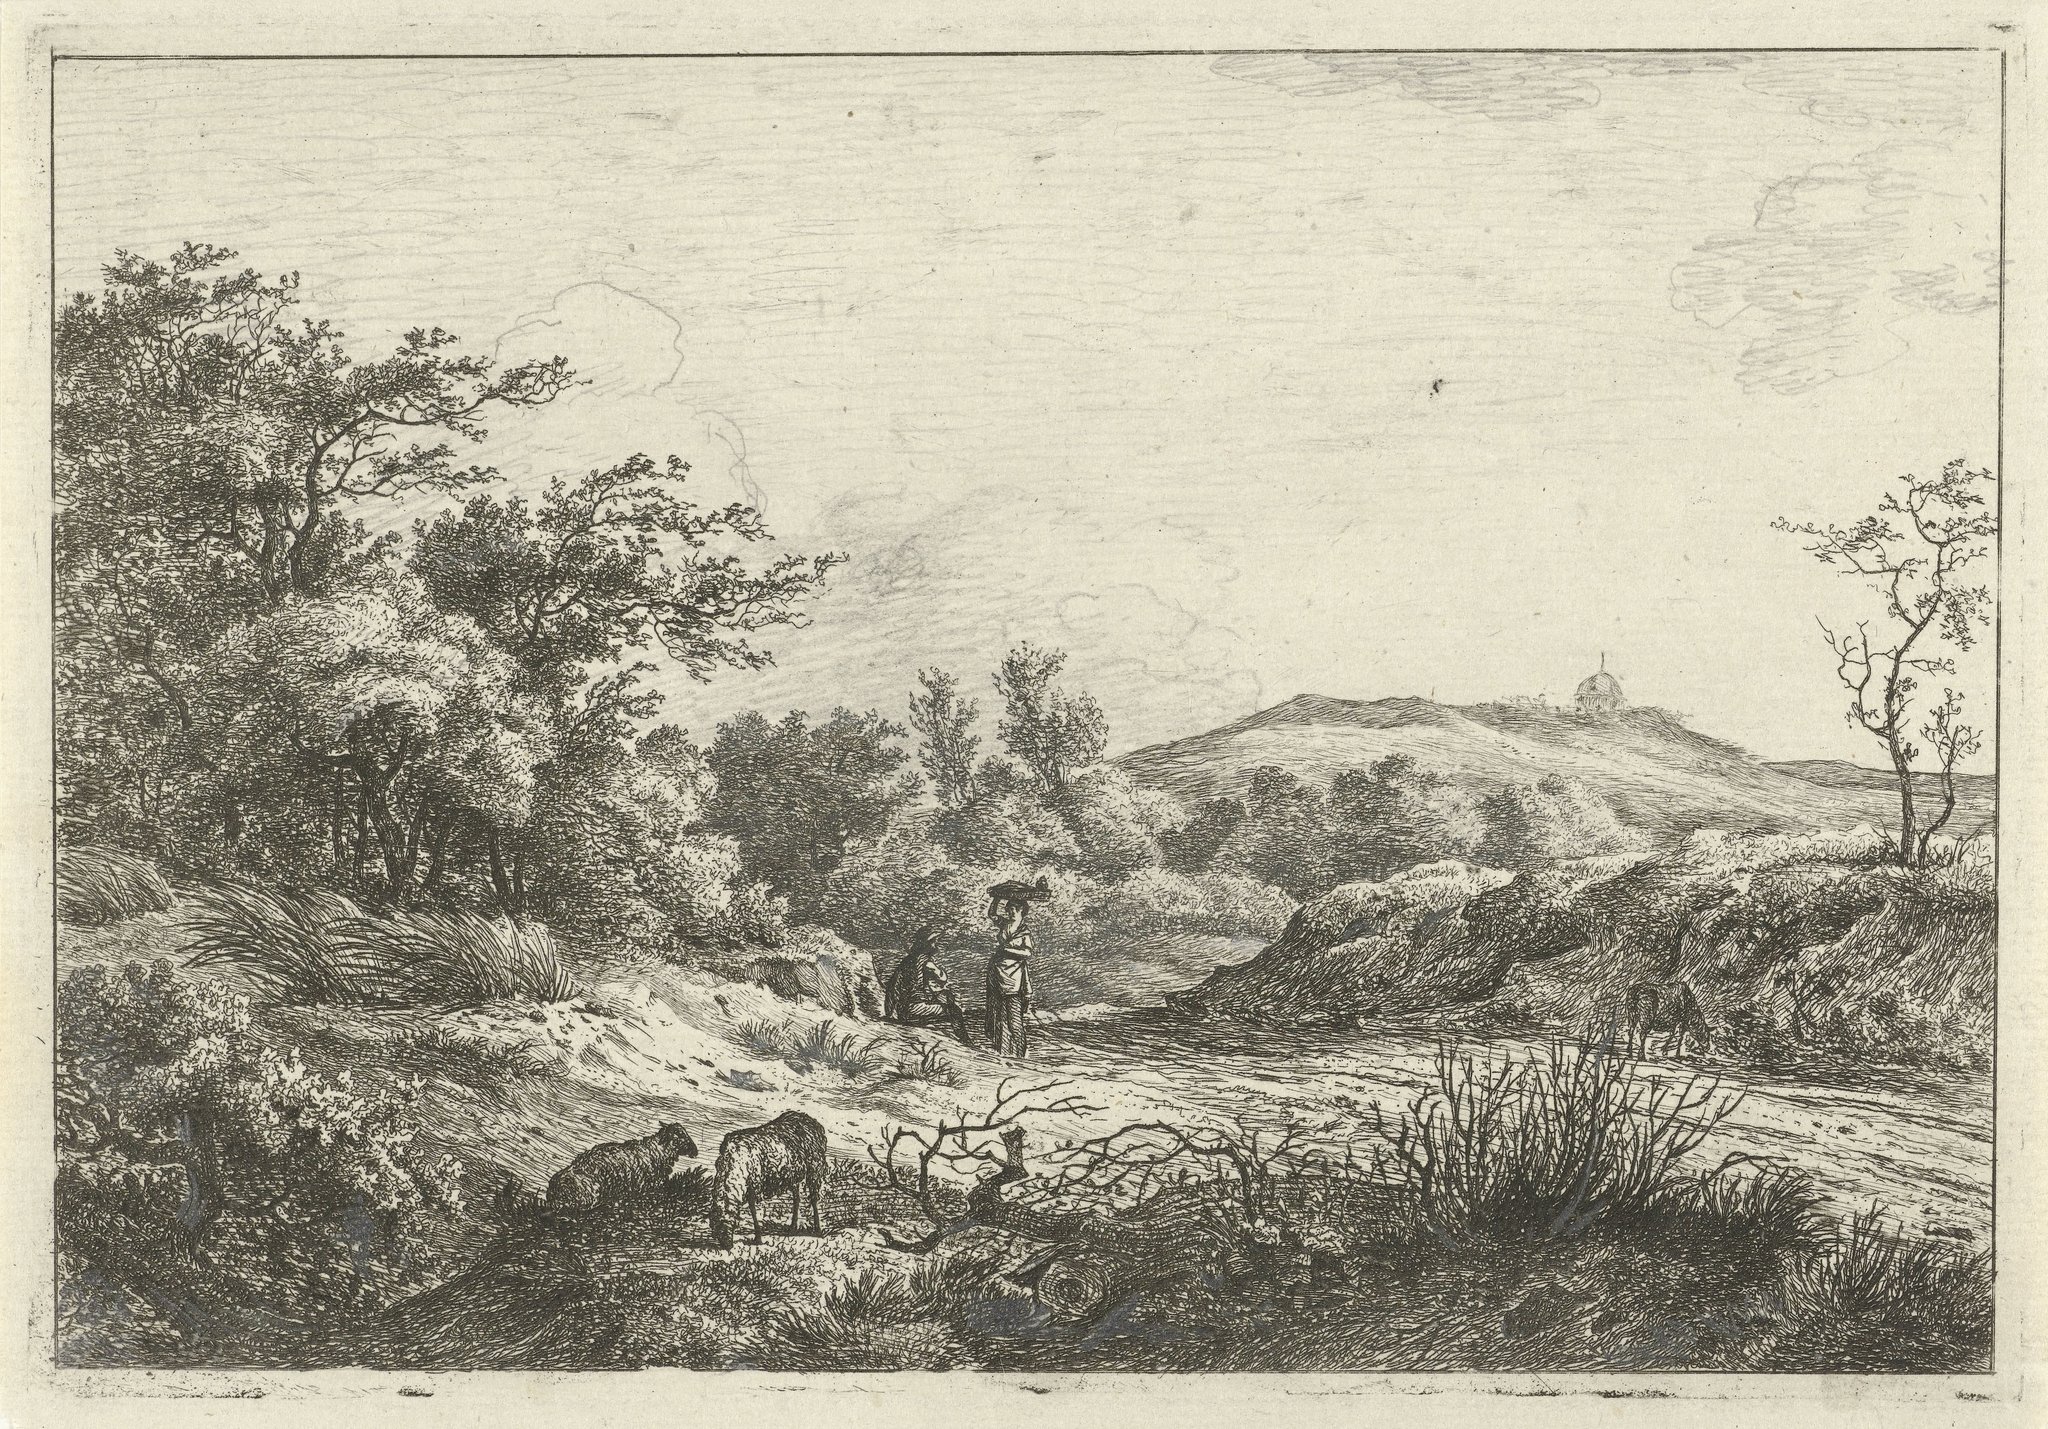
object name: print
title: Landschap met herder en vrouw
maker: hermanus fock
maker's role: conservator, draughtsman, painter, print maker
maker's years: 1766-1822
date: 1781-1822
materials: paper, pencil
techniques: etching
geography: amsterdam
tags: herding, herdsman, herdswoman, shepherd, shepherdess, cowherd, etc., low hill country (+ landscape with figures, staffage)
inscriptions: collector's mark: Lugt 2228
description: Heuvellandschap met op de voorgrond twee schapen. Een vrouw met een mand op haar hoofd staat bij een zittende herder. Op de achtergrond een koepelgebouw op een heuvel.